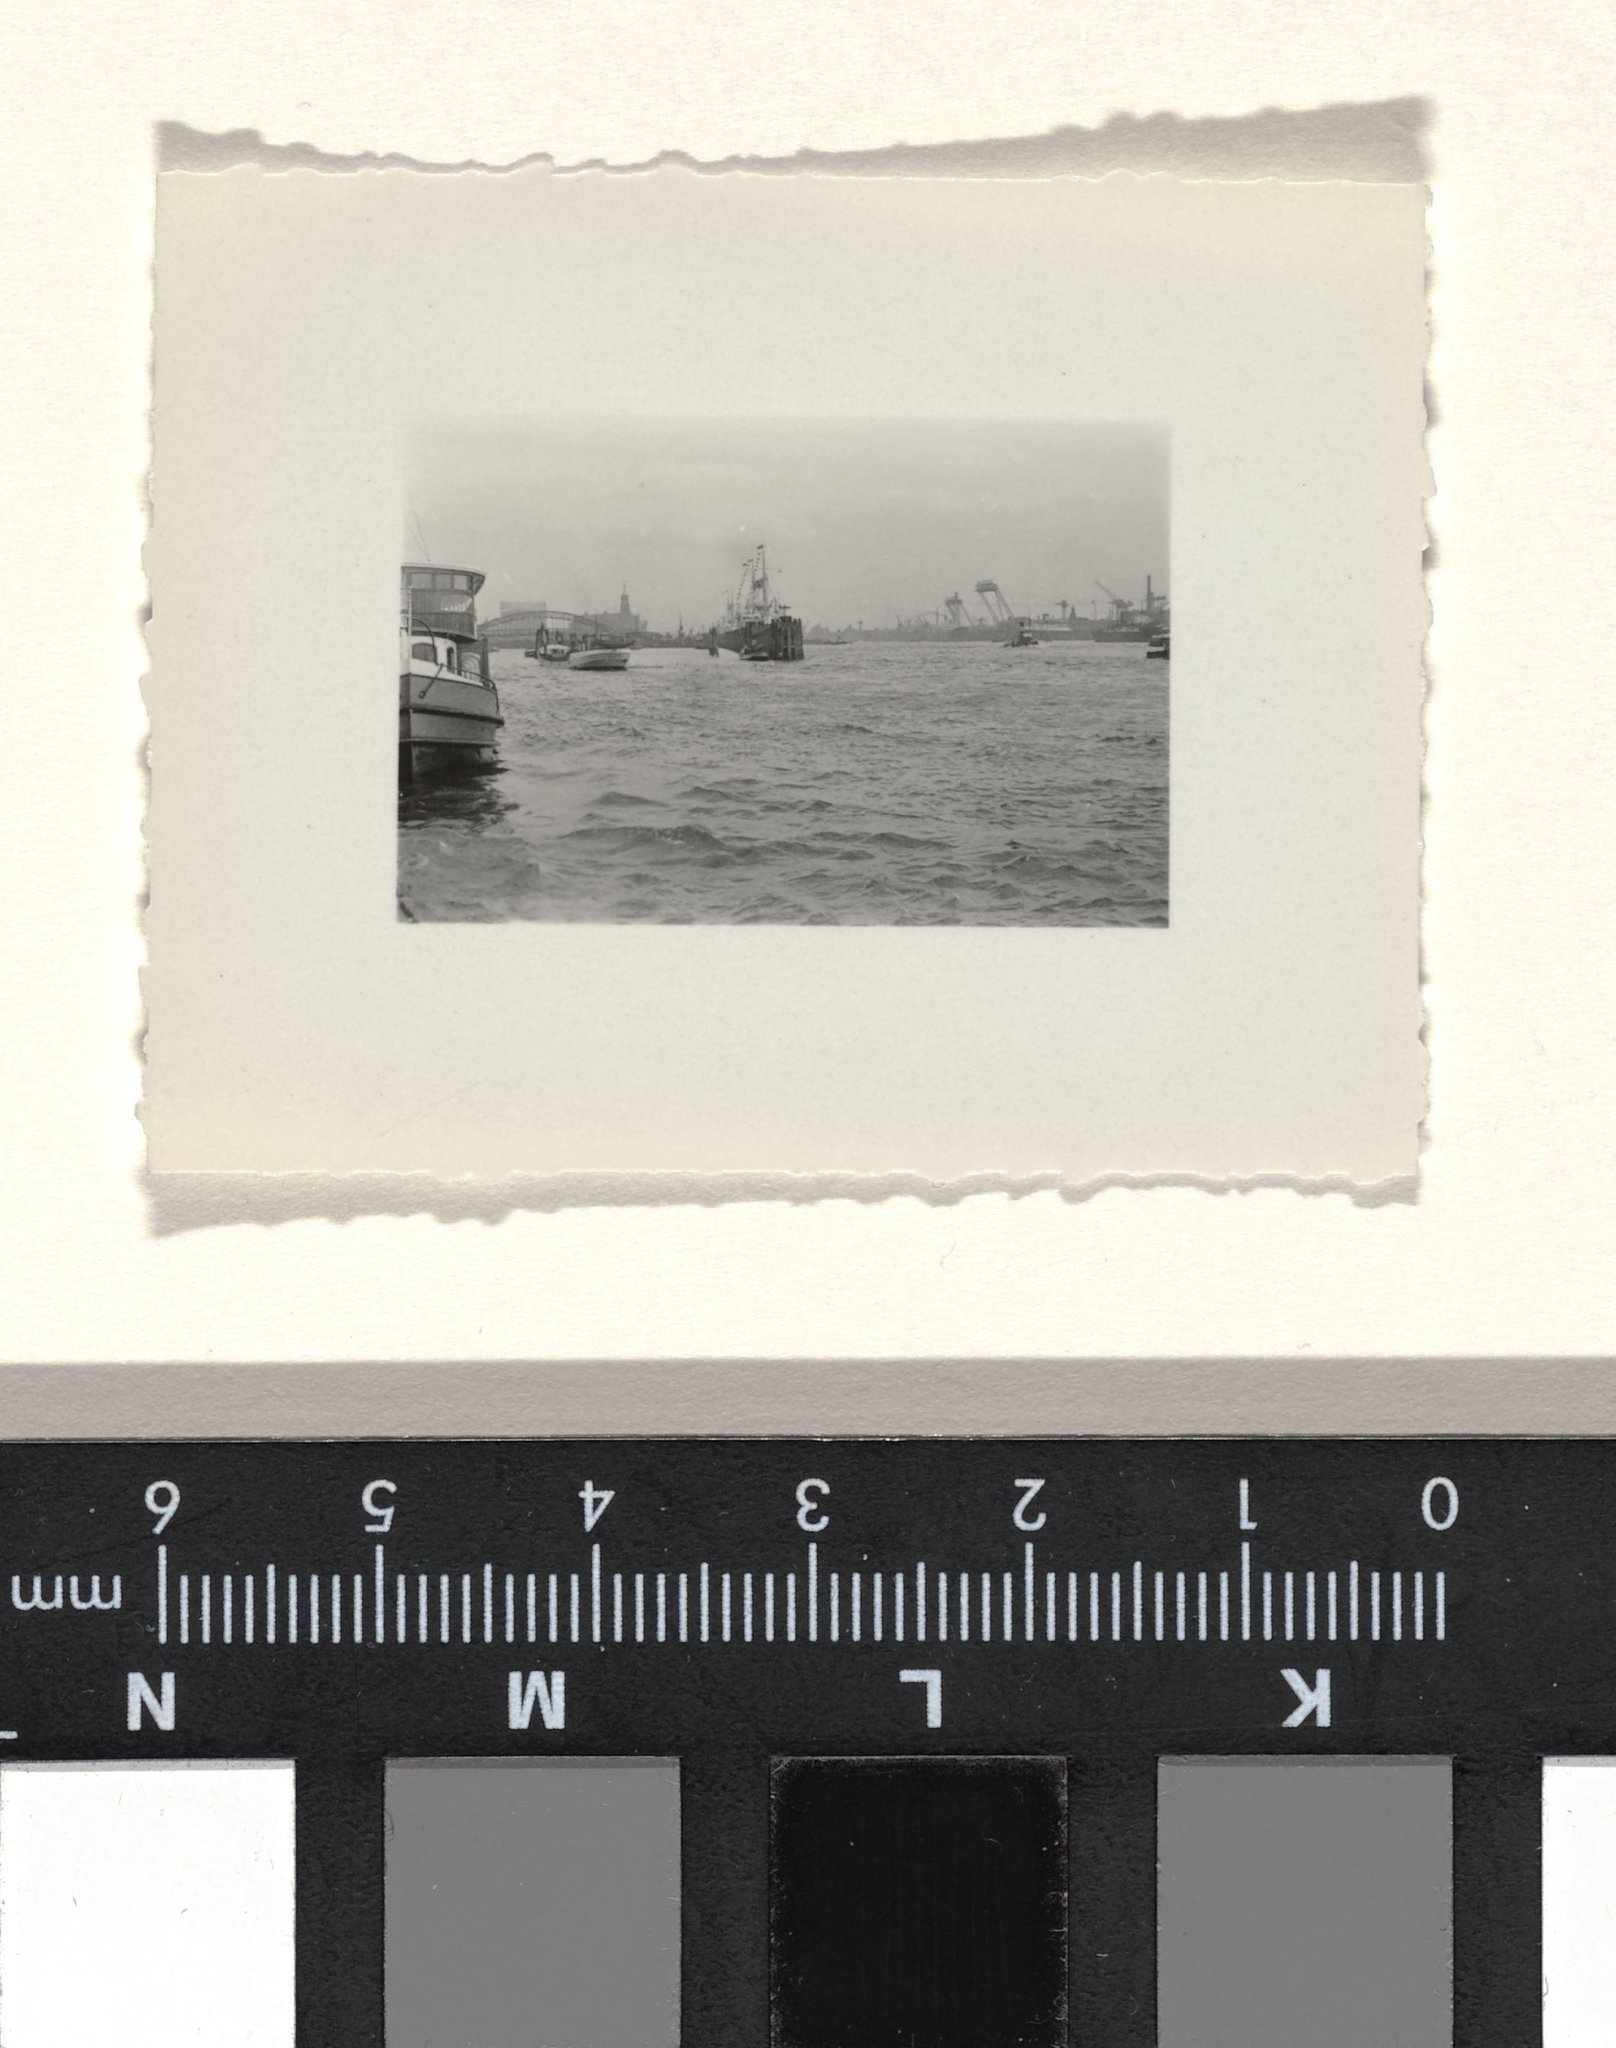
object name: photograph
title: Varende schepen met een haven op de achtergrond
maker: Anonymous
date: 1920-1965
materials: photographic support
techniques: gelatin silver print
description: Varende schepen met een haven op de achtergrond.